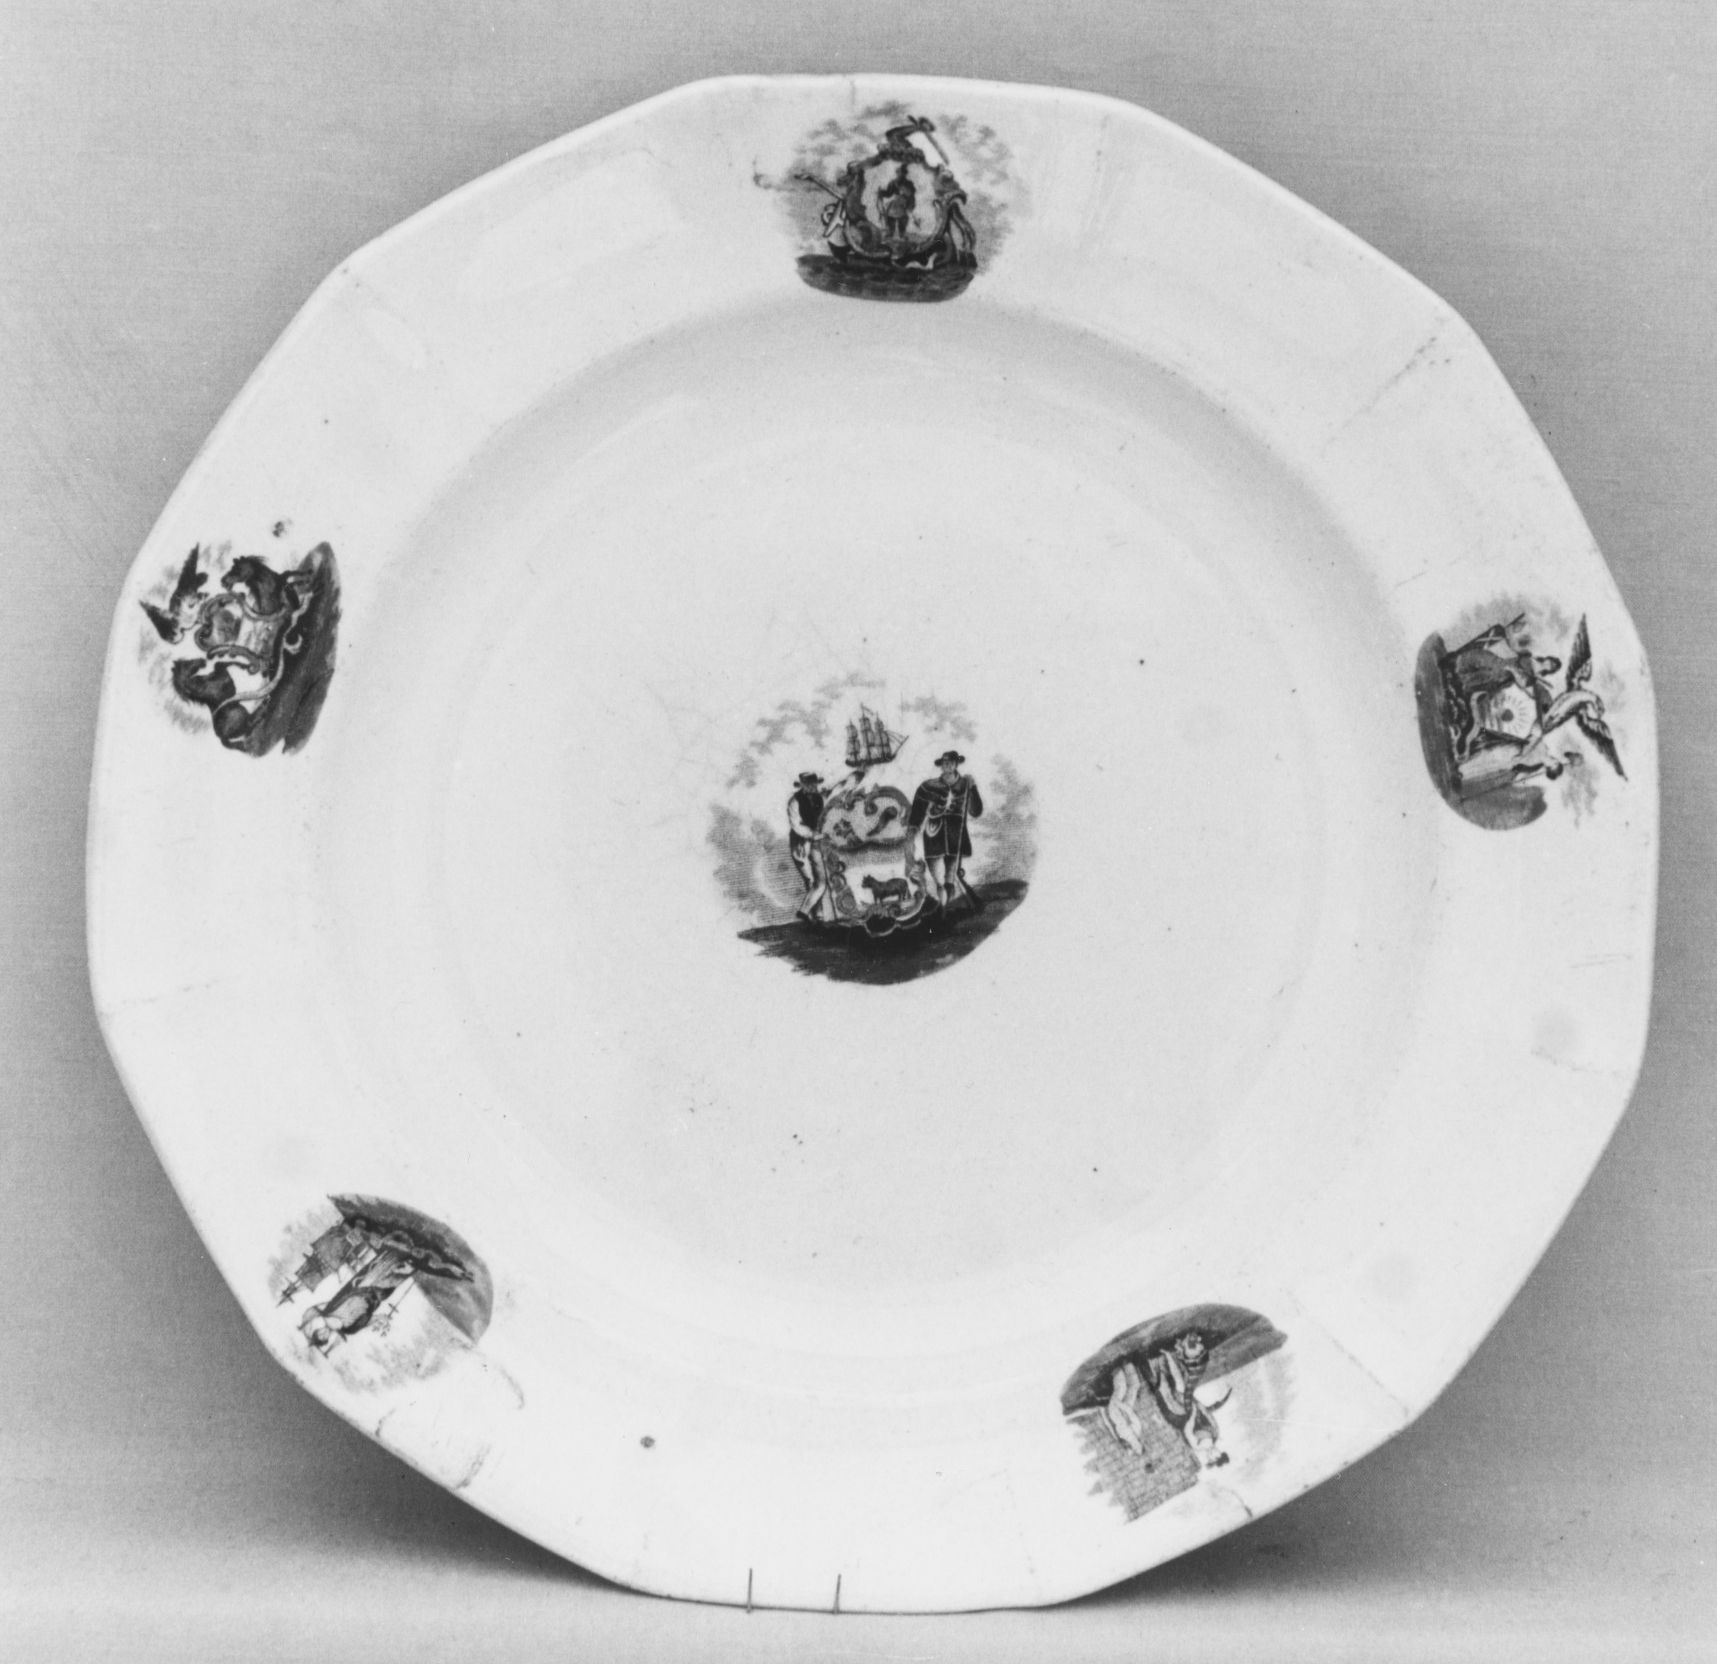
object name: plate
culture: british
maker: mellor, venables & co.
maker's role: maker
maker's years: 1831-1851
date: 1834-1851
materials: earthenware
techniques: transfer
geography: england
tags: men,coat of arms